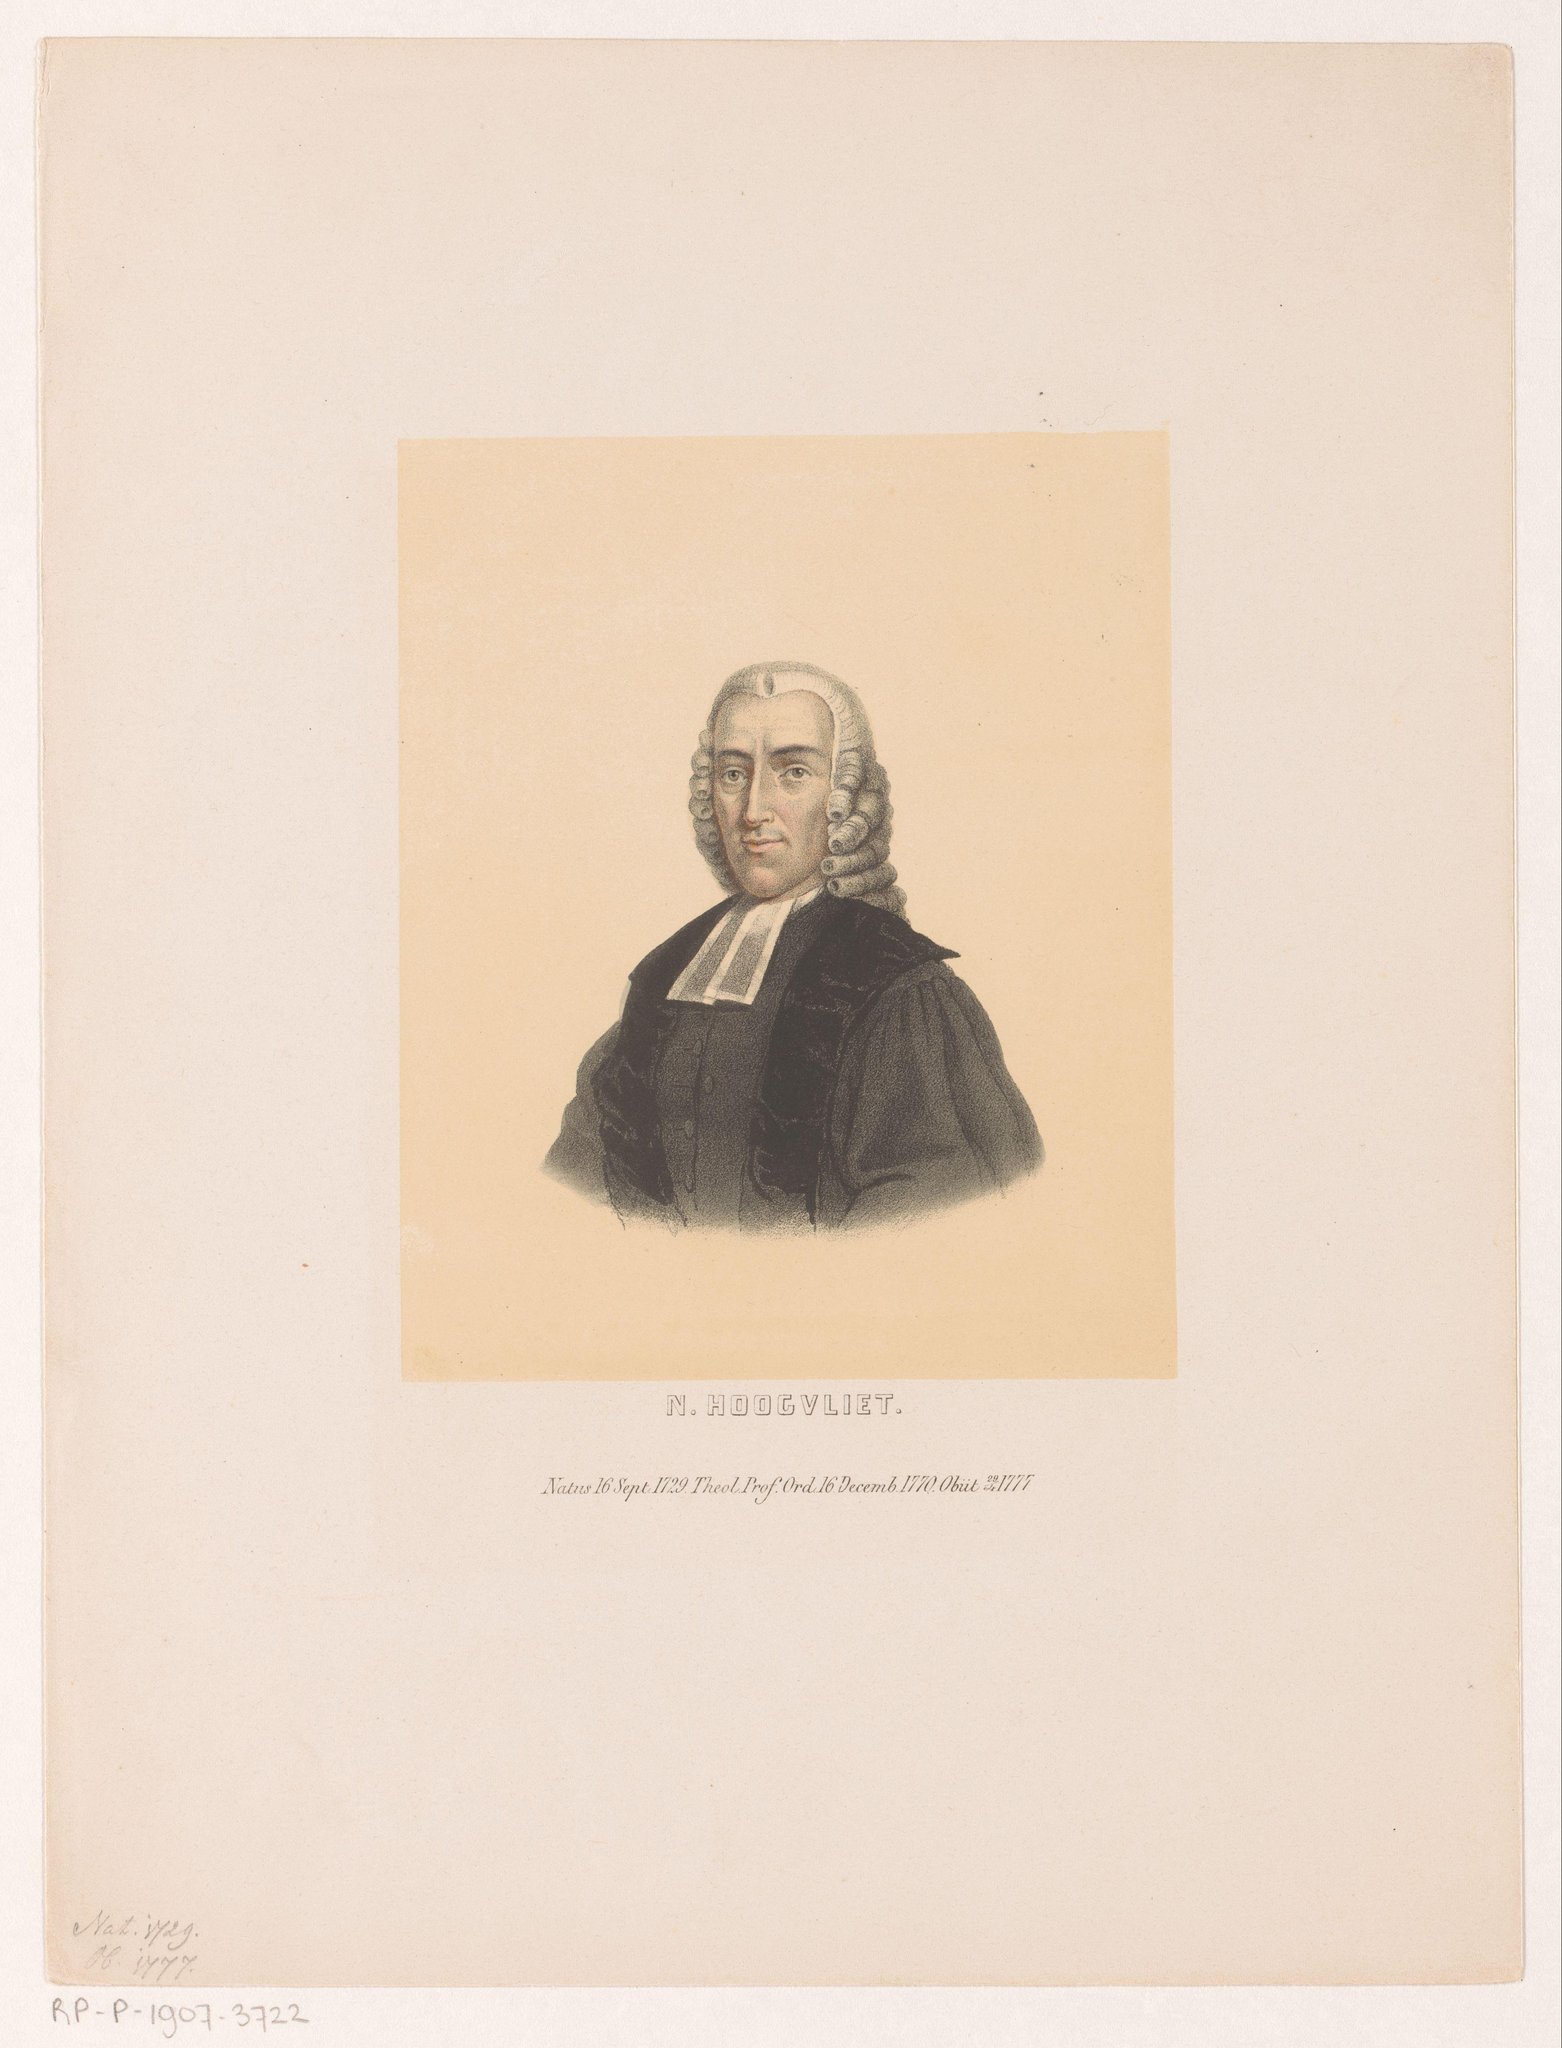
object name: print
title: N. Hoogvliet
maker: leendert springer (i)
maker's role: draughtsman, painter, print maker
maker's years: 1789-1871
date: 1850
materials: paper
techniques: lithograph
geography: leiden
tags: delft, historical persons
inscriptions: collector's mark: Lugt 2228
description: Prent uit: Springer, Leendert. Galerij van hoogleeraren aan de Hoogeschool te Leijden, naar de oorspronkelijke afbeeldsels op de Senaat-zaal aldaar berustende. Leiden: Springer, Leendert., s.a. [circa 1850].